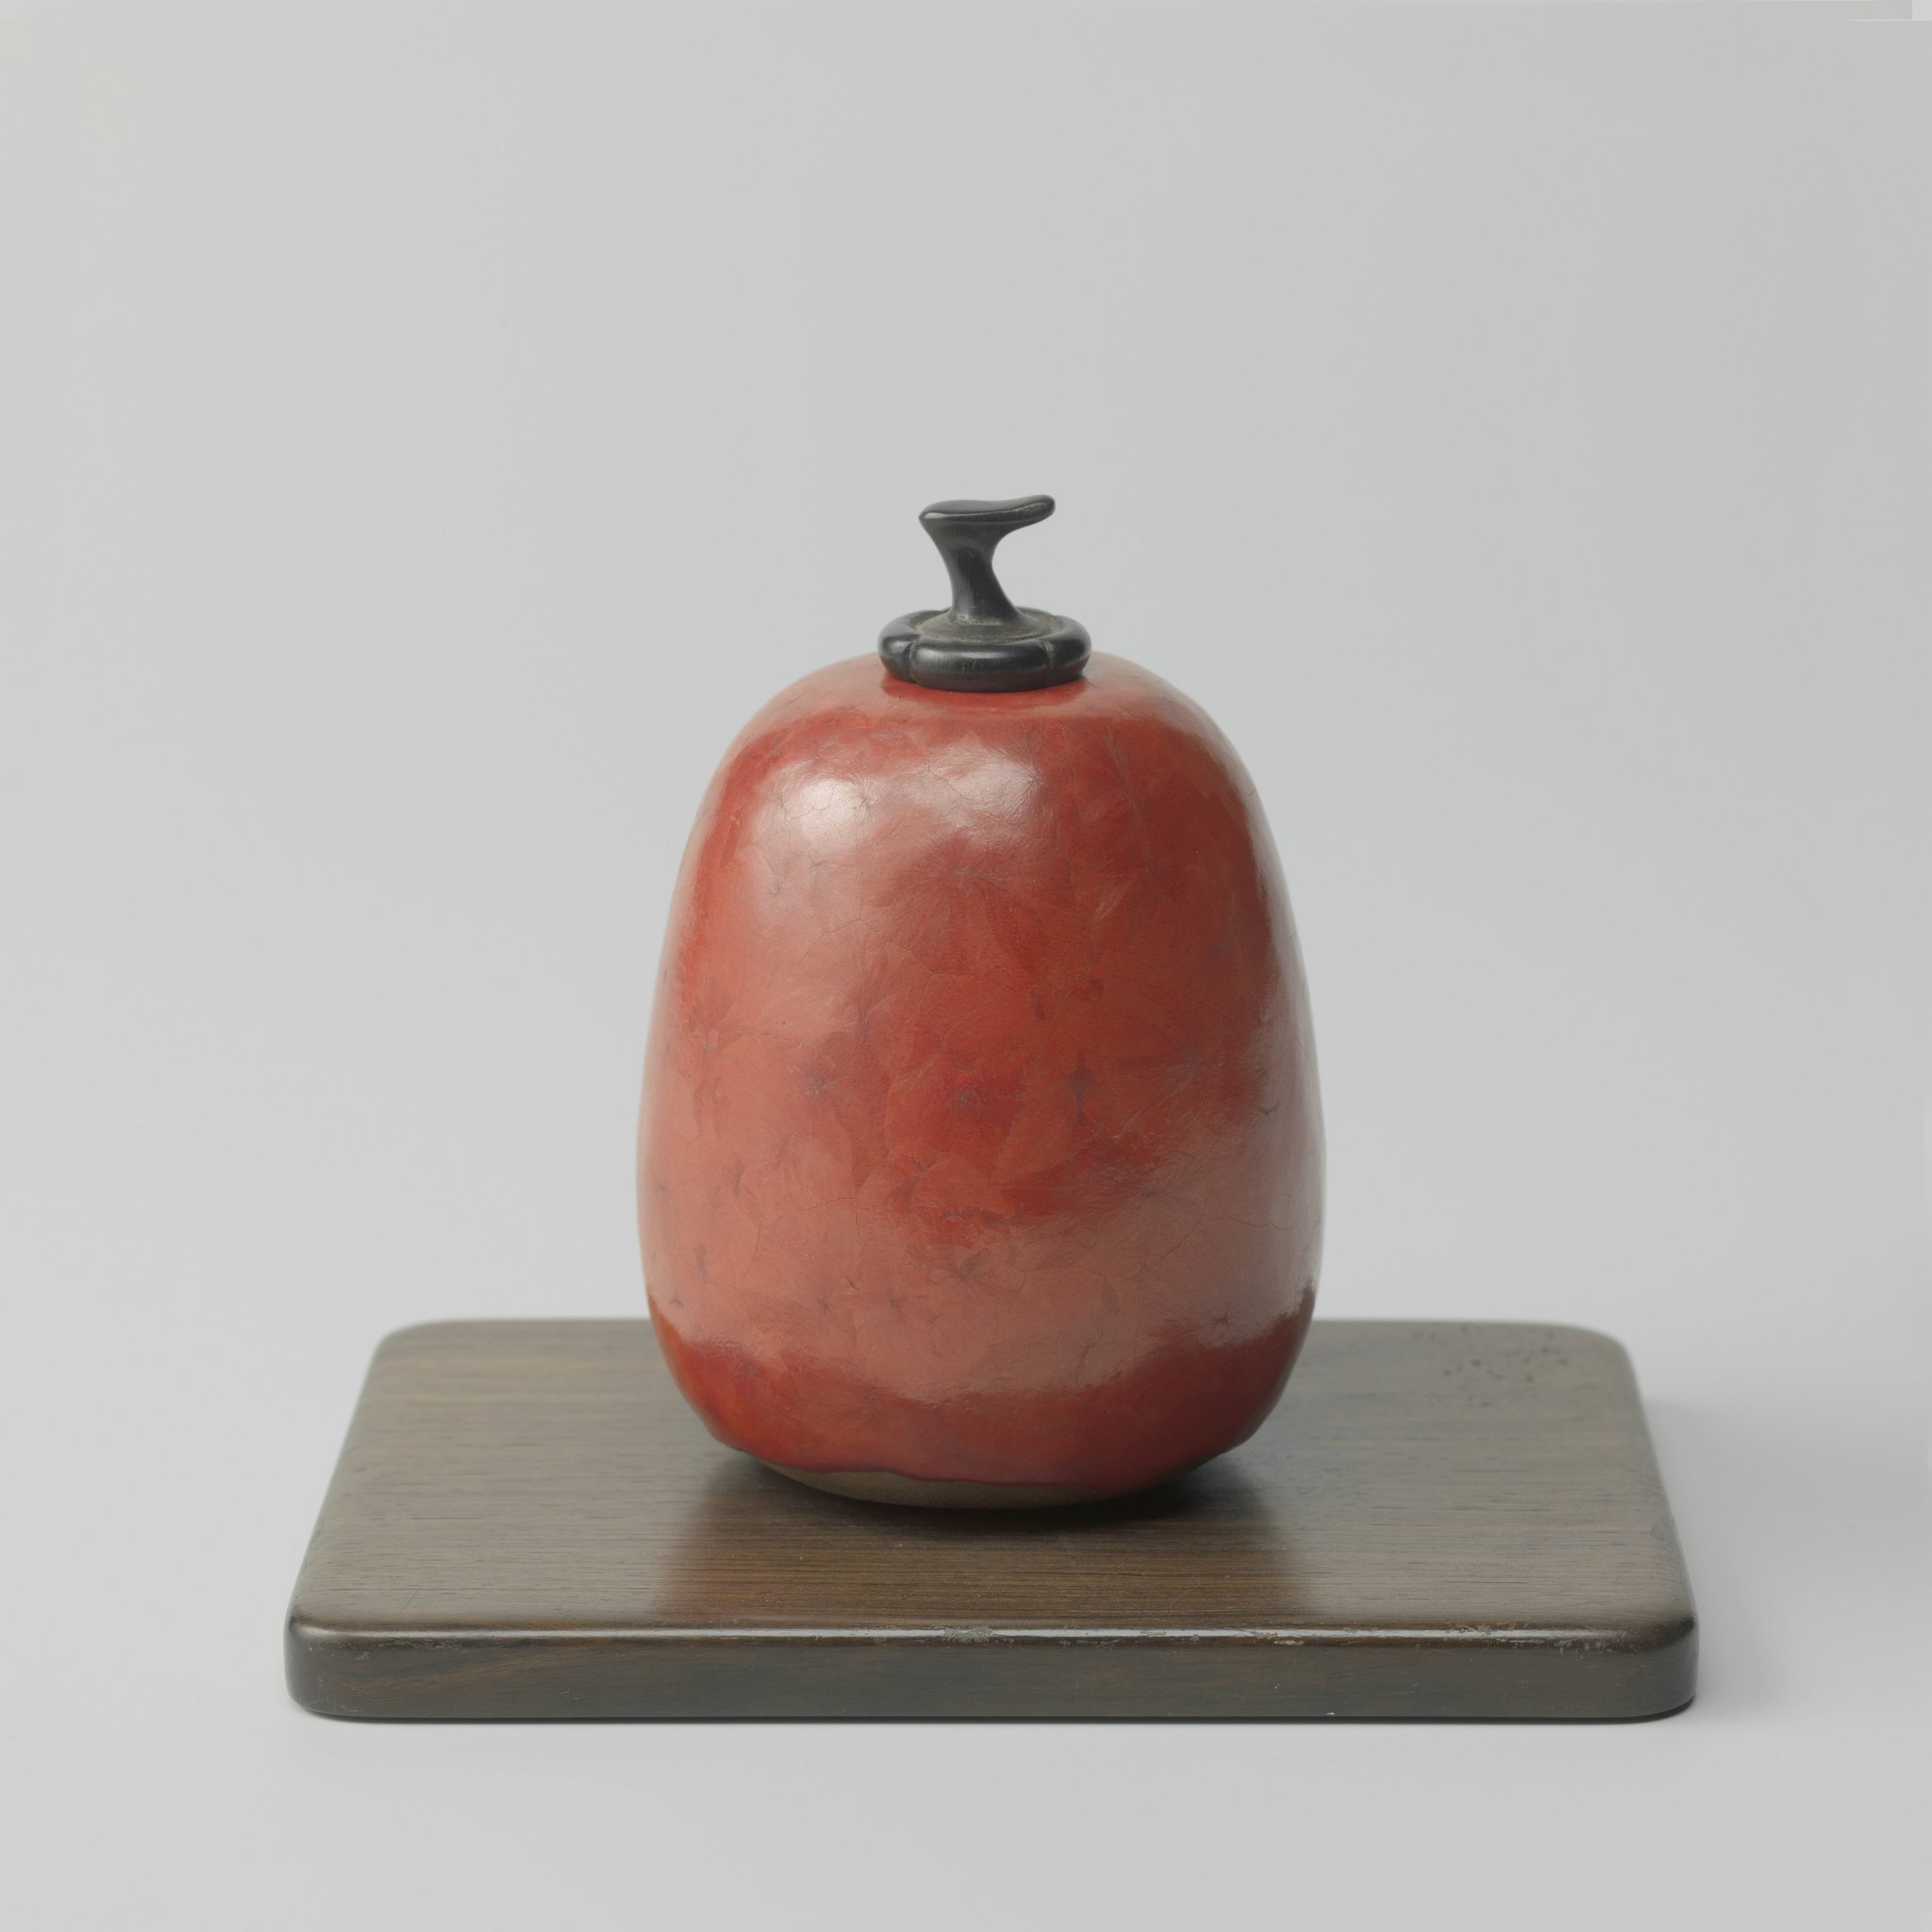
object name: pot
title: Pot, peervormig, met rode glazuur en een houten stopje, staande op een houten plankje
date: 1925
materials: stoneware, wood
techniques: cutting, vitrification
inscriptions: mark: ‘Hsim’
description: Jar. Stoneware with wooden cover. Marseille-Montredon, c. 1925, by Henry Simmen, the cover by his wife O'kin Simmen.